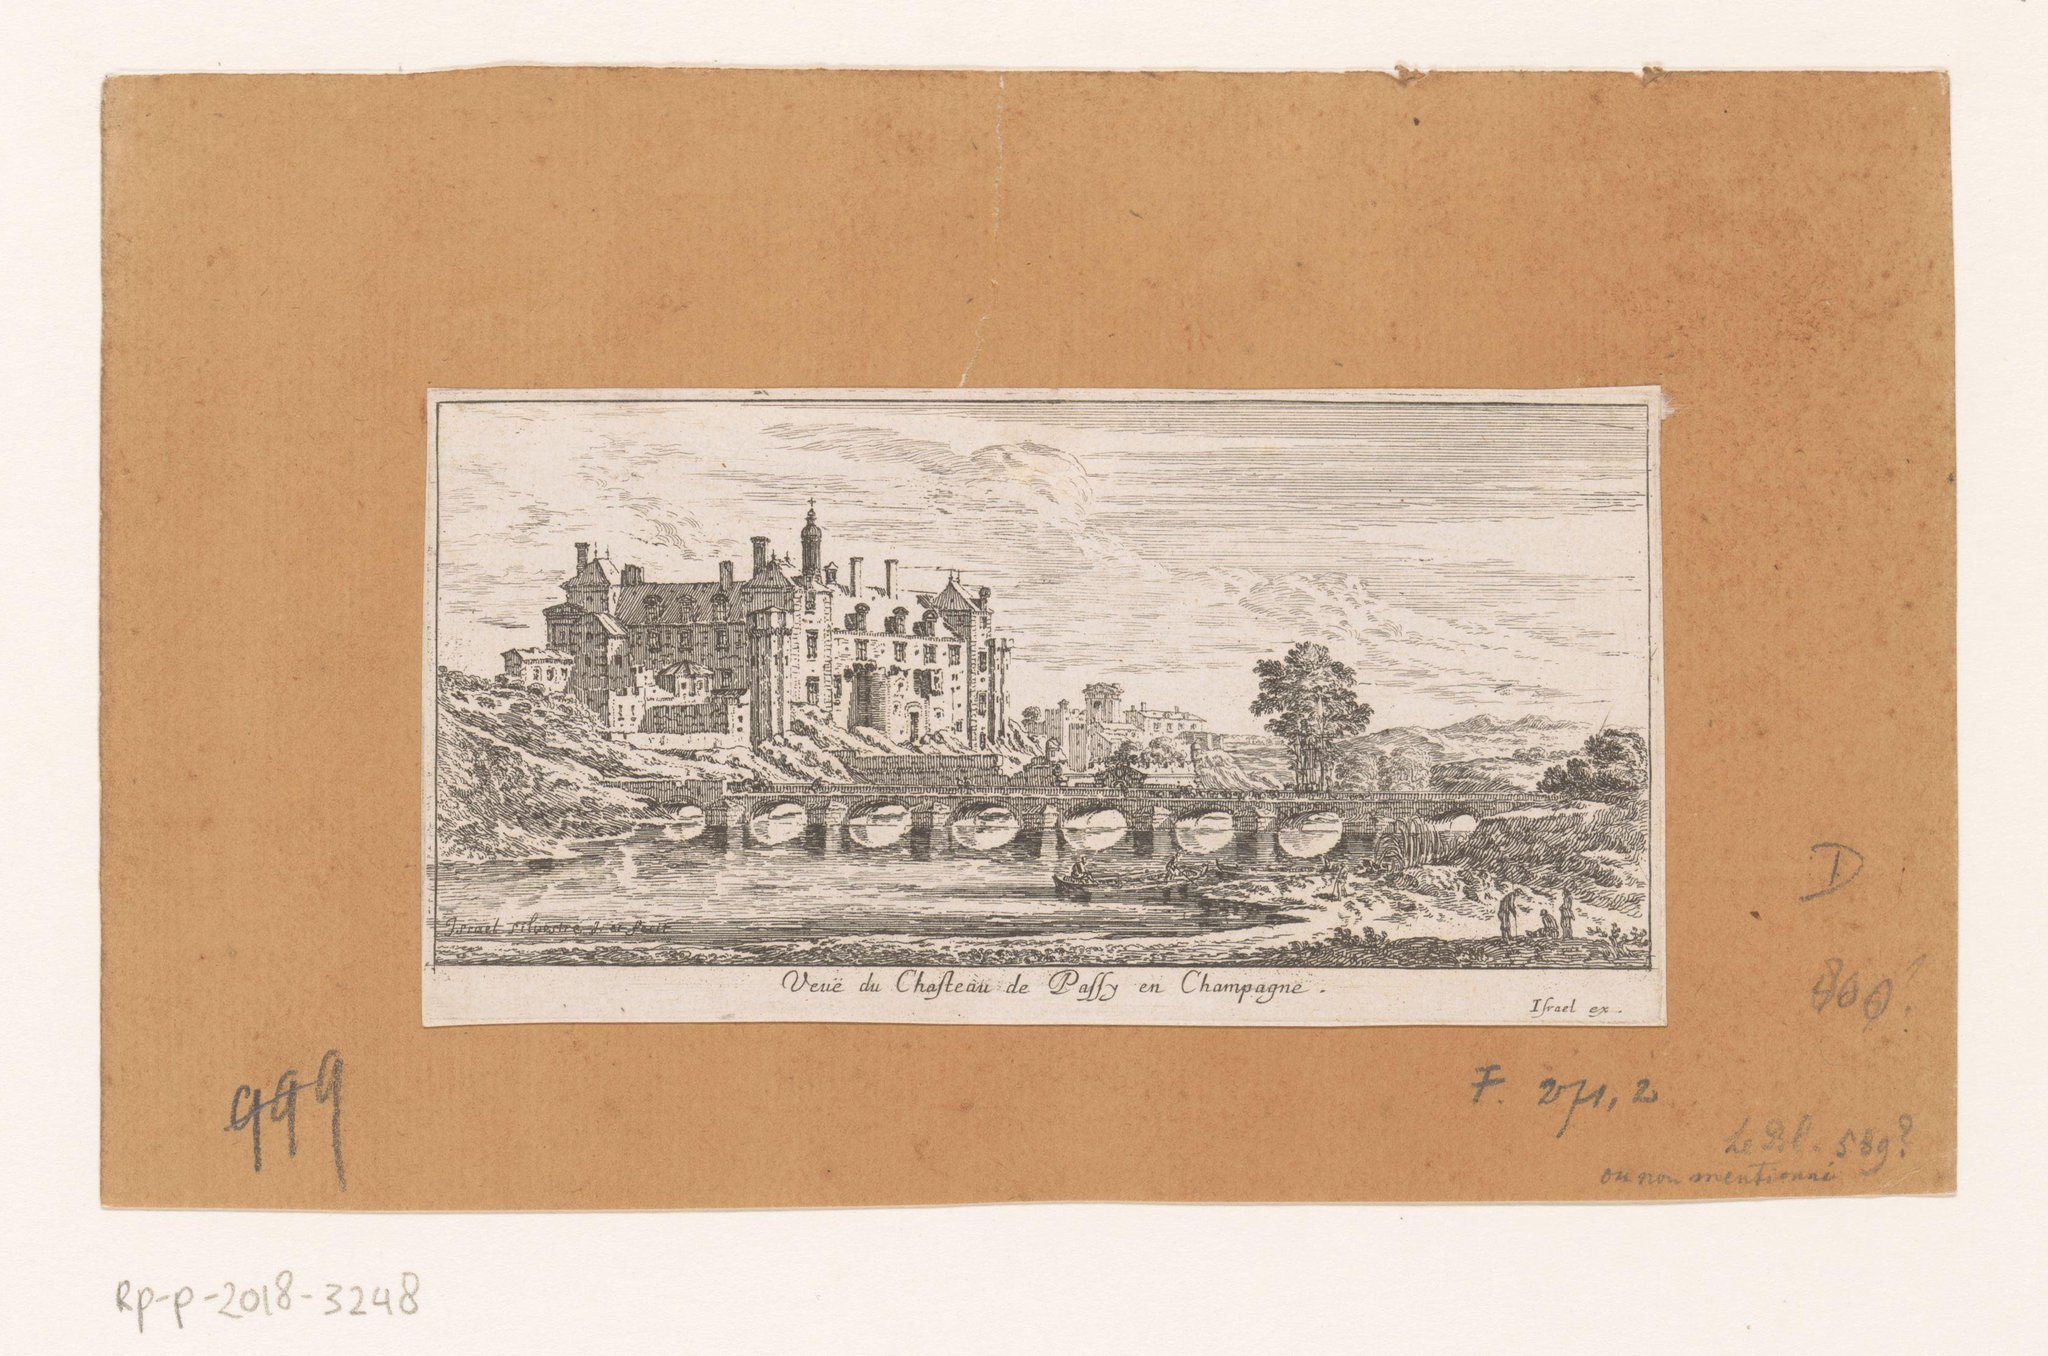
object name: print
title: Veuë du Chasteau de Passy en Champagne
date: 1631-1661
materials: paper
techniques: etching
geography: paris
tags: castle, landscape with bridge, viaduct or aqueduct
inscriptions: collector's mark: Lugt 2228